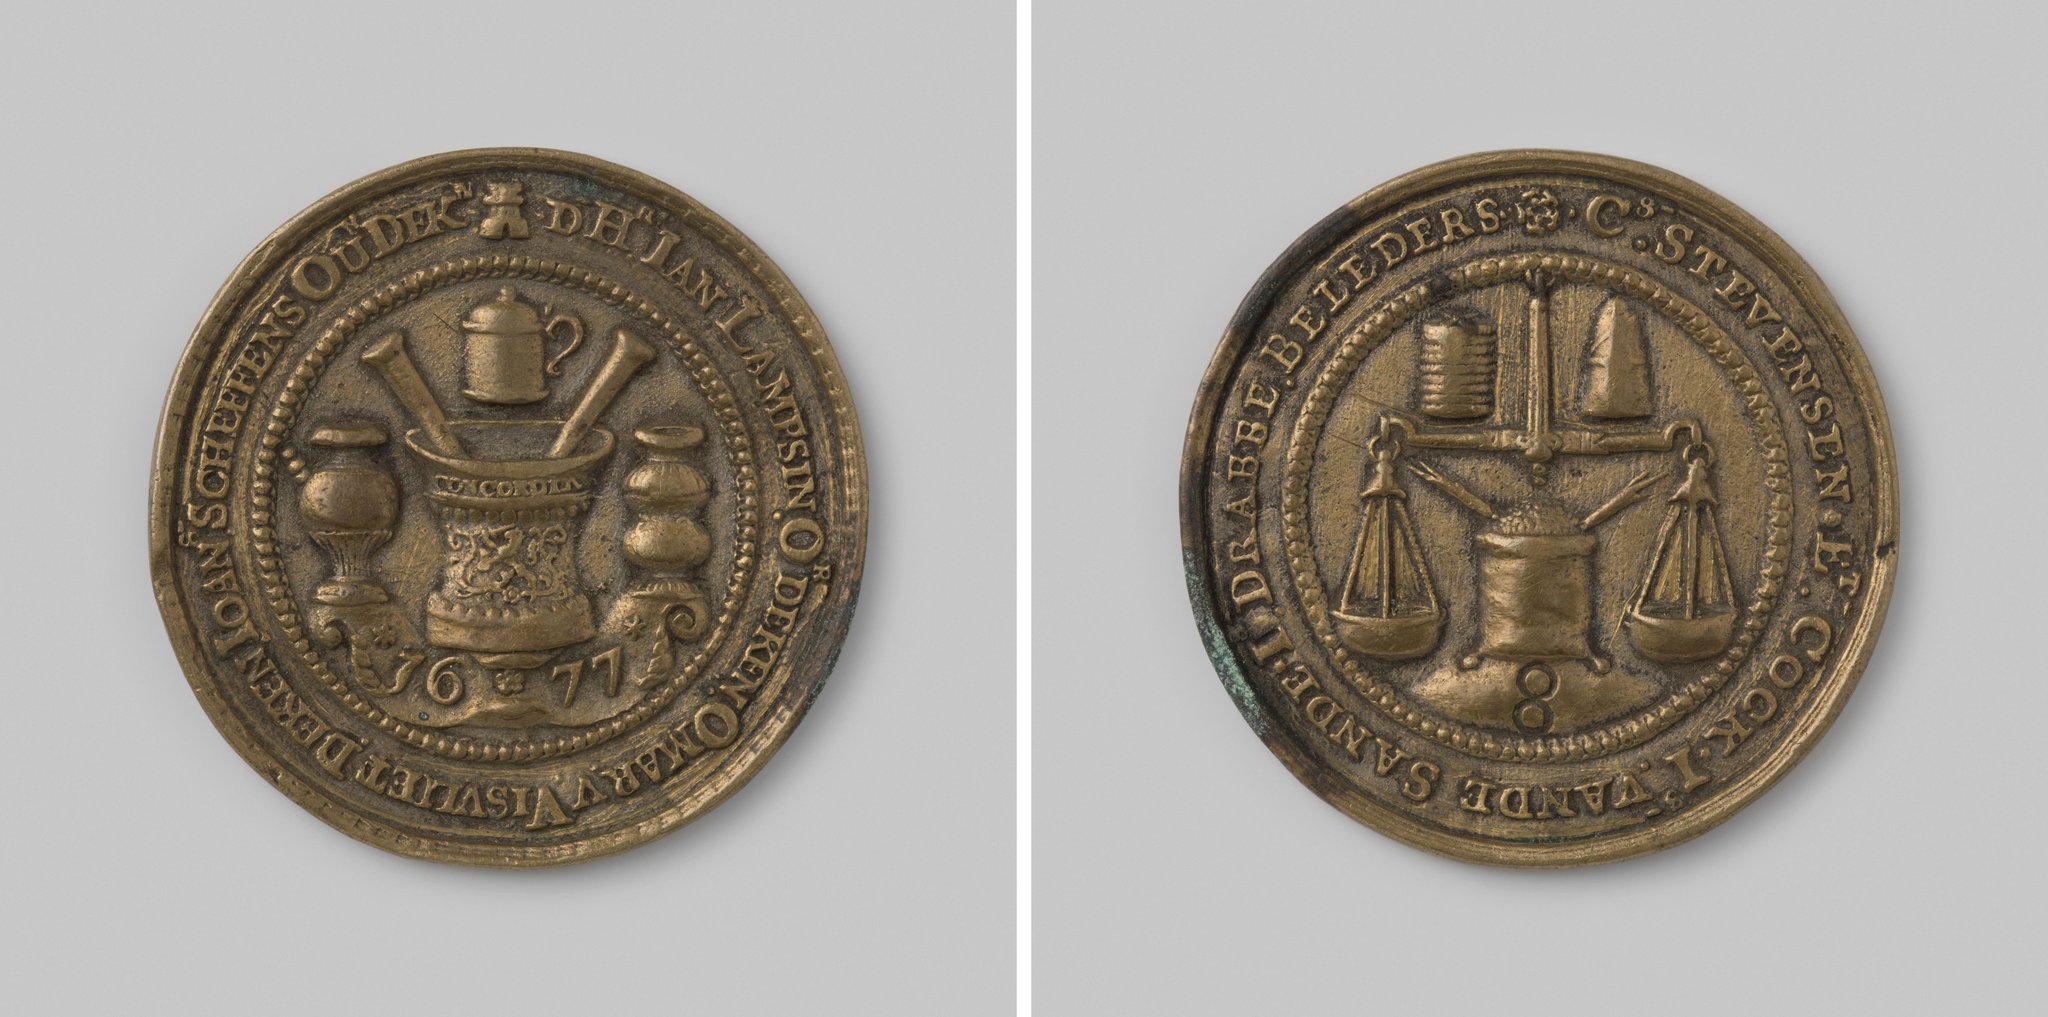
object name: history medal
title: Presentiepenning van het Kruideniers-, apothekers- en drogistengilde te Middelburg, 1677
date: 1677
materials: brass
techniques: casting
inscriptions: circumscription: ‘(burcht) D HR IAN LAMPSIN OR DEKEN OMAR V VISVLIET DEKEN IOANS SCHEFFENS OUN DEKN’, inscription: ‘8’, circumscription: ‘(roos) CS STEVENSEN ET COCK IS VANDE SANDE S DRABBE BELEDERS’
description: Gegoten messing penning, op de voorzijde een vijzel waarop het Generaliteitswapen en CONCORDIA, omringd door drie potten en een lint met 1677, met omschrift, op de keerzijde een balans waar omheen een rol tabak, een suikerbrood en een volle baal, onderaan gegraveerd het cijfer 8, met omschrift